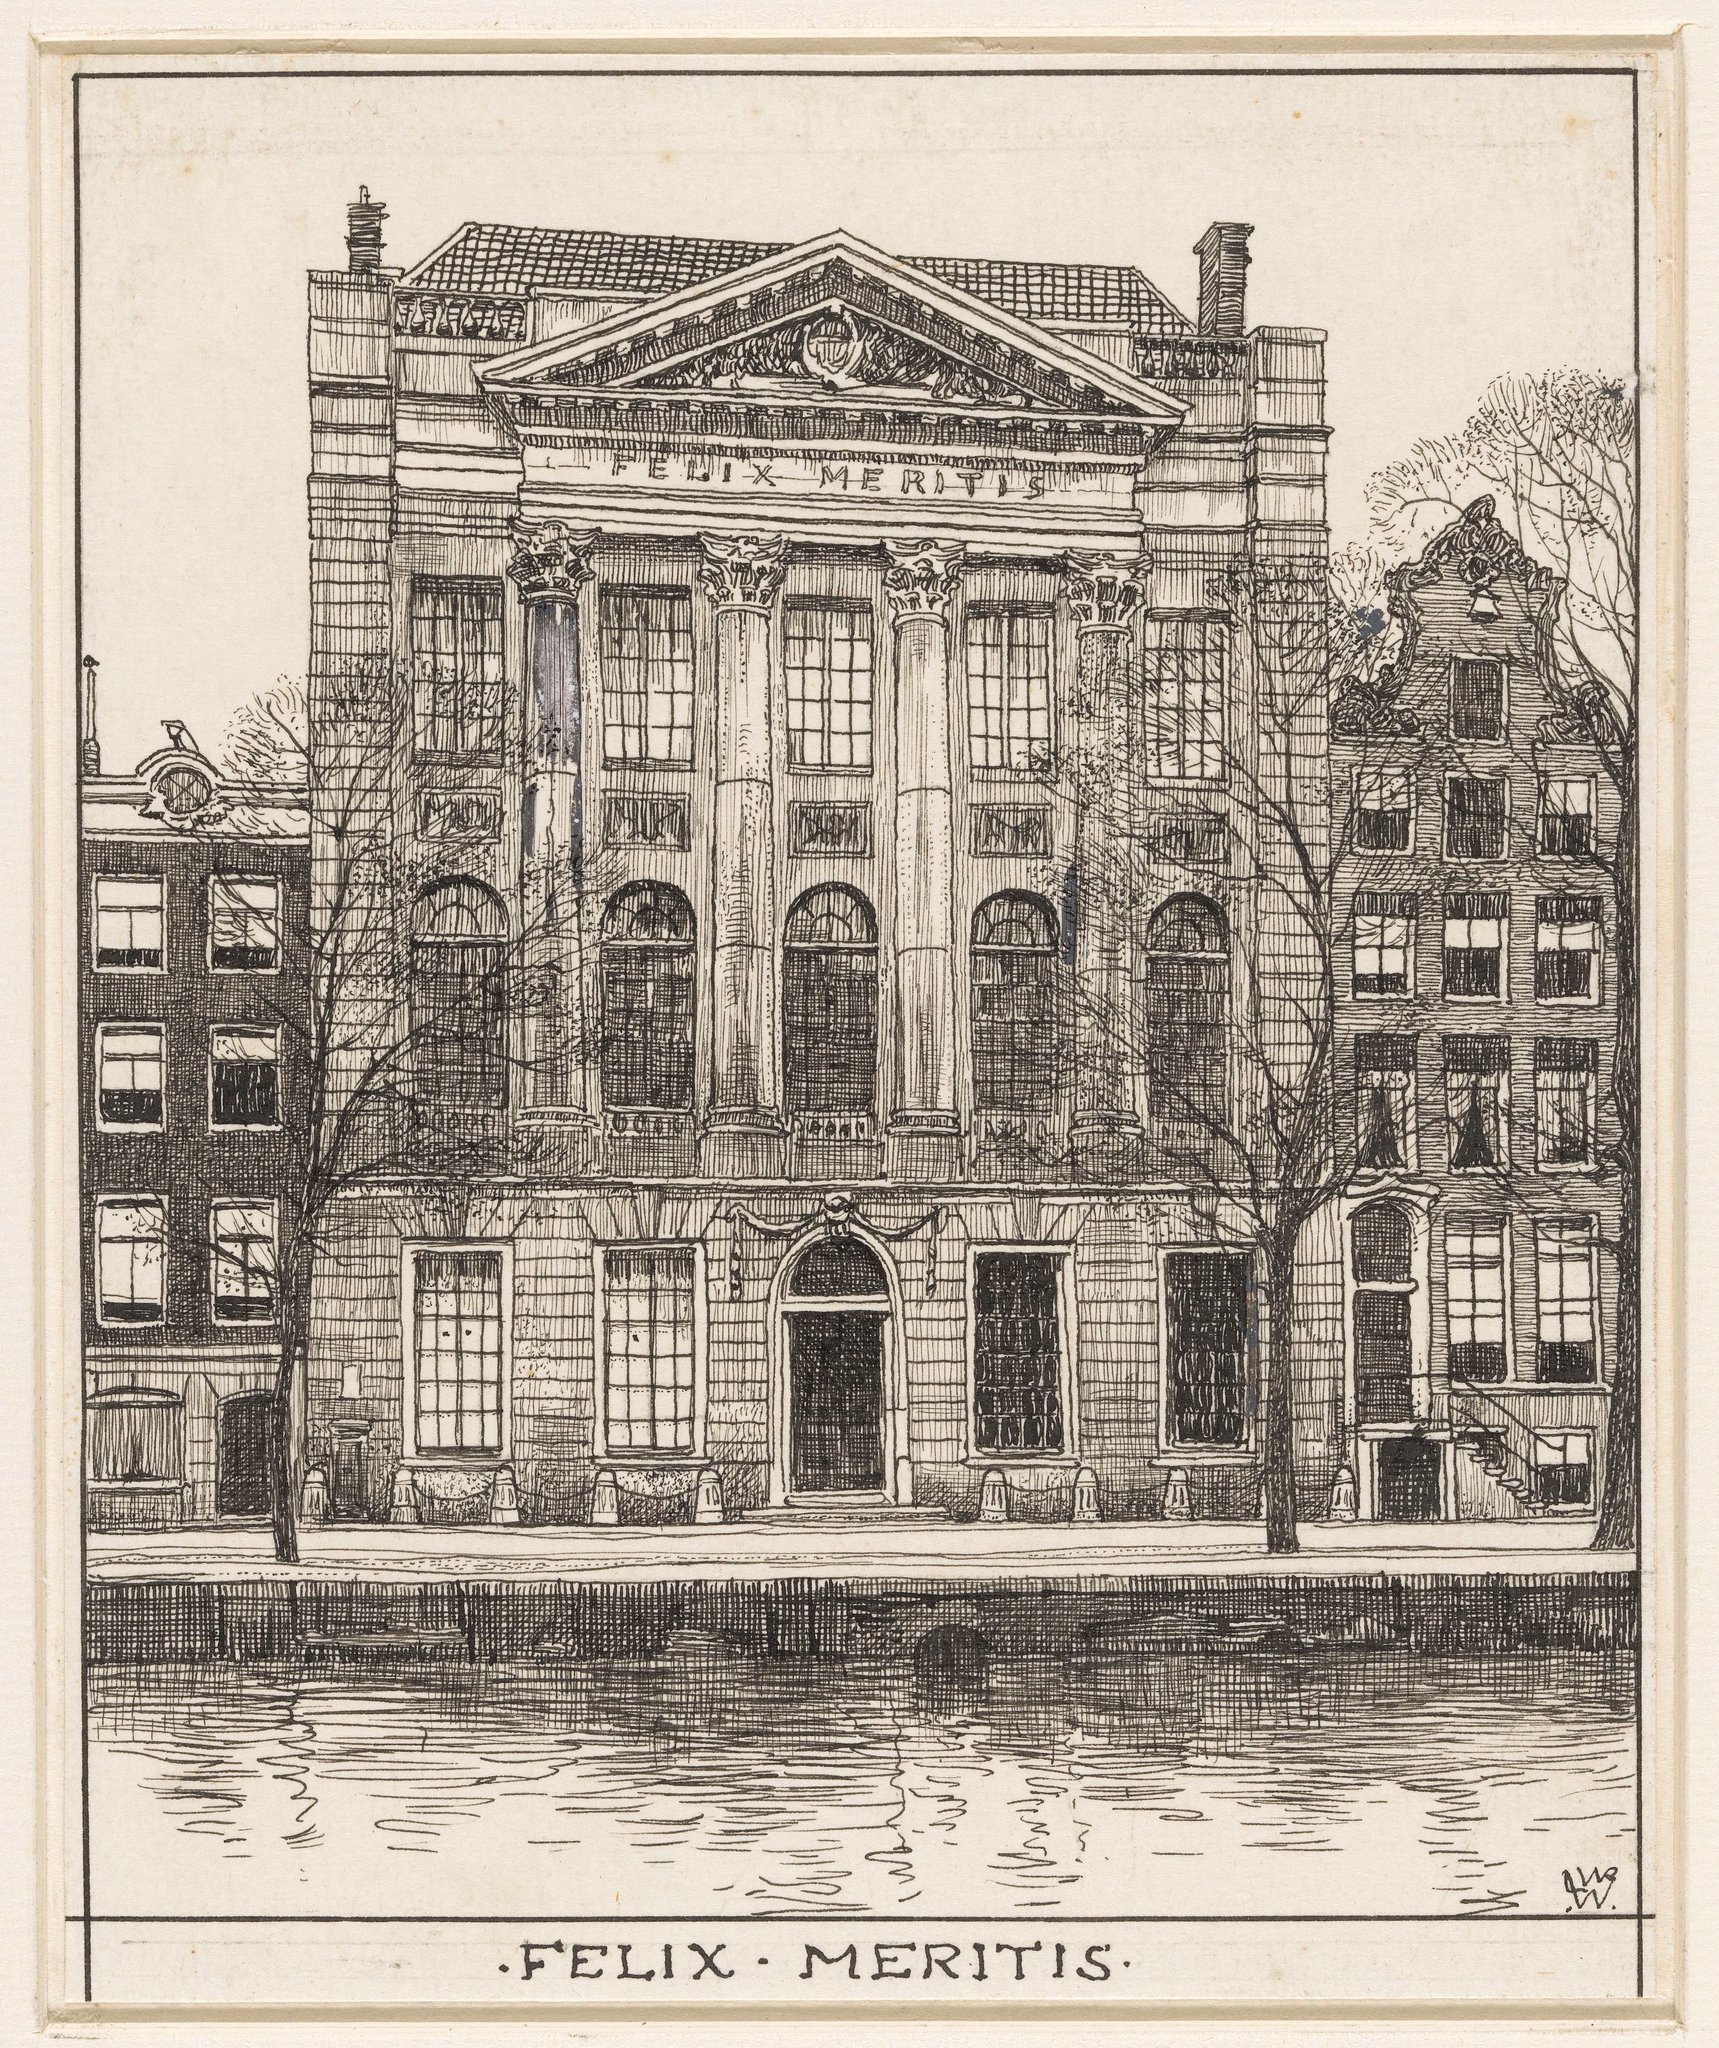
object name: drawing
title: Felix Meritis te Amsterdam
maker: willem wenckebach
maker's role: designer, draughtsman, painter, print maker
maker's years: 1860-1937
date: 1870-1926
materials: paint, ink, paper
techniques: pen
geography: amsterdam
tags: urban housing, amsterdam